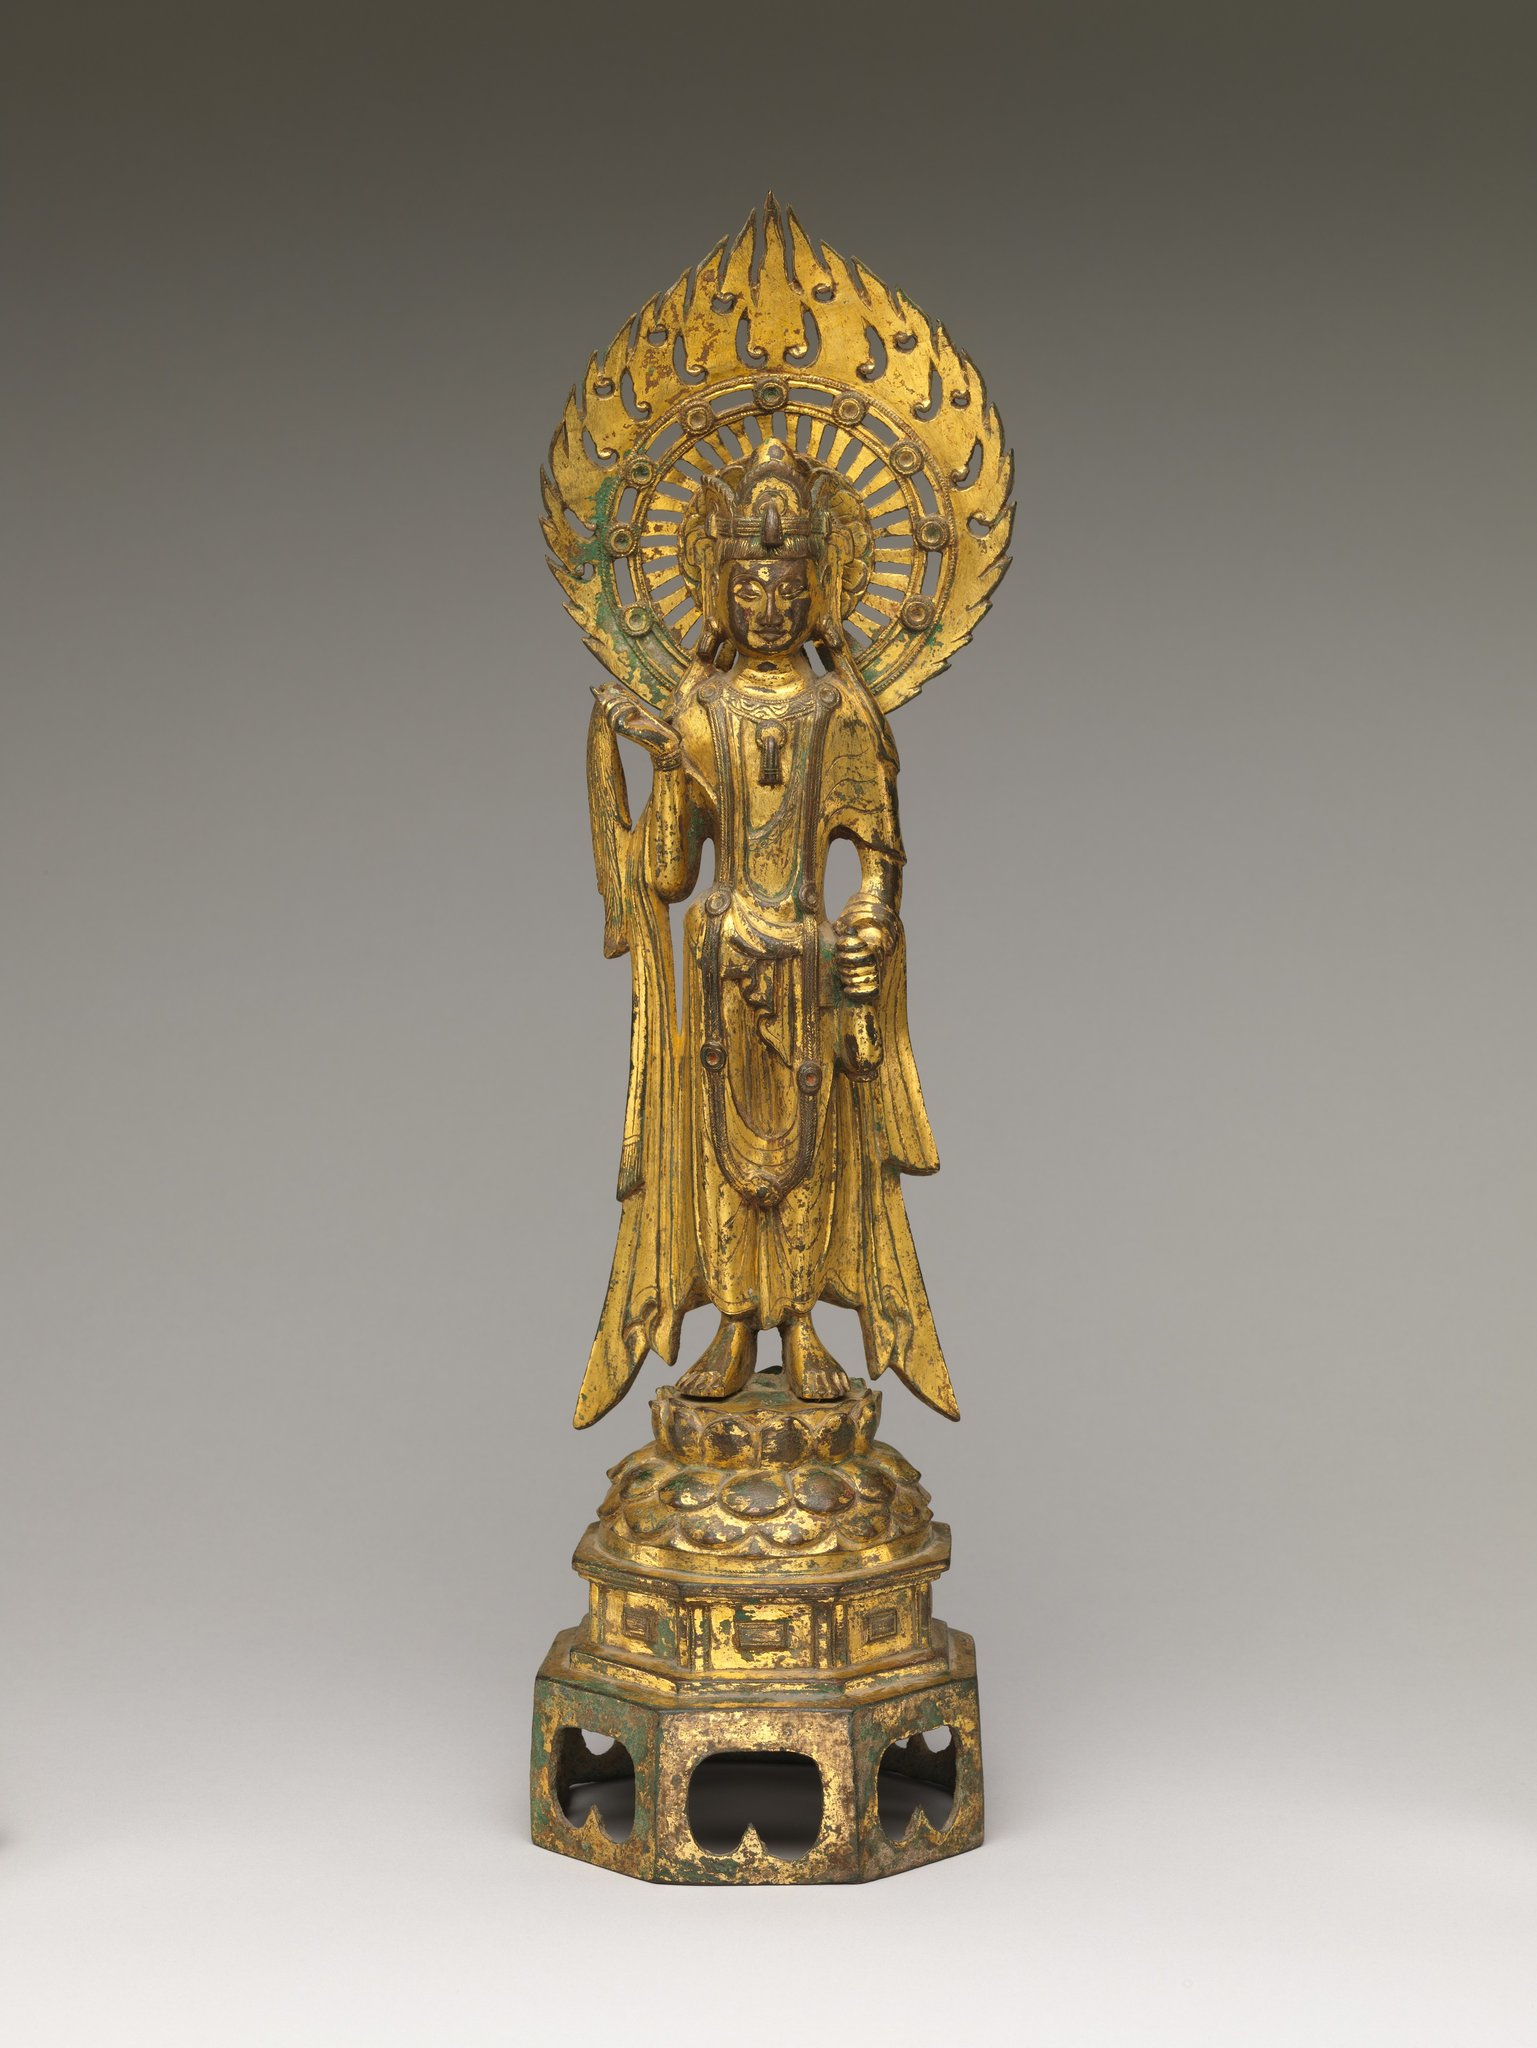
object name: figure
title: Bodhisattva Avalokiteshvara (Guanyin)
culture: chinese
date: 567-600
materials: gilt bronze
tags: buddhism,avalokiteshvara,bodhisattvas